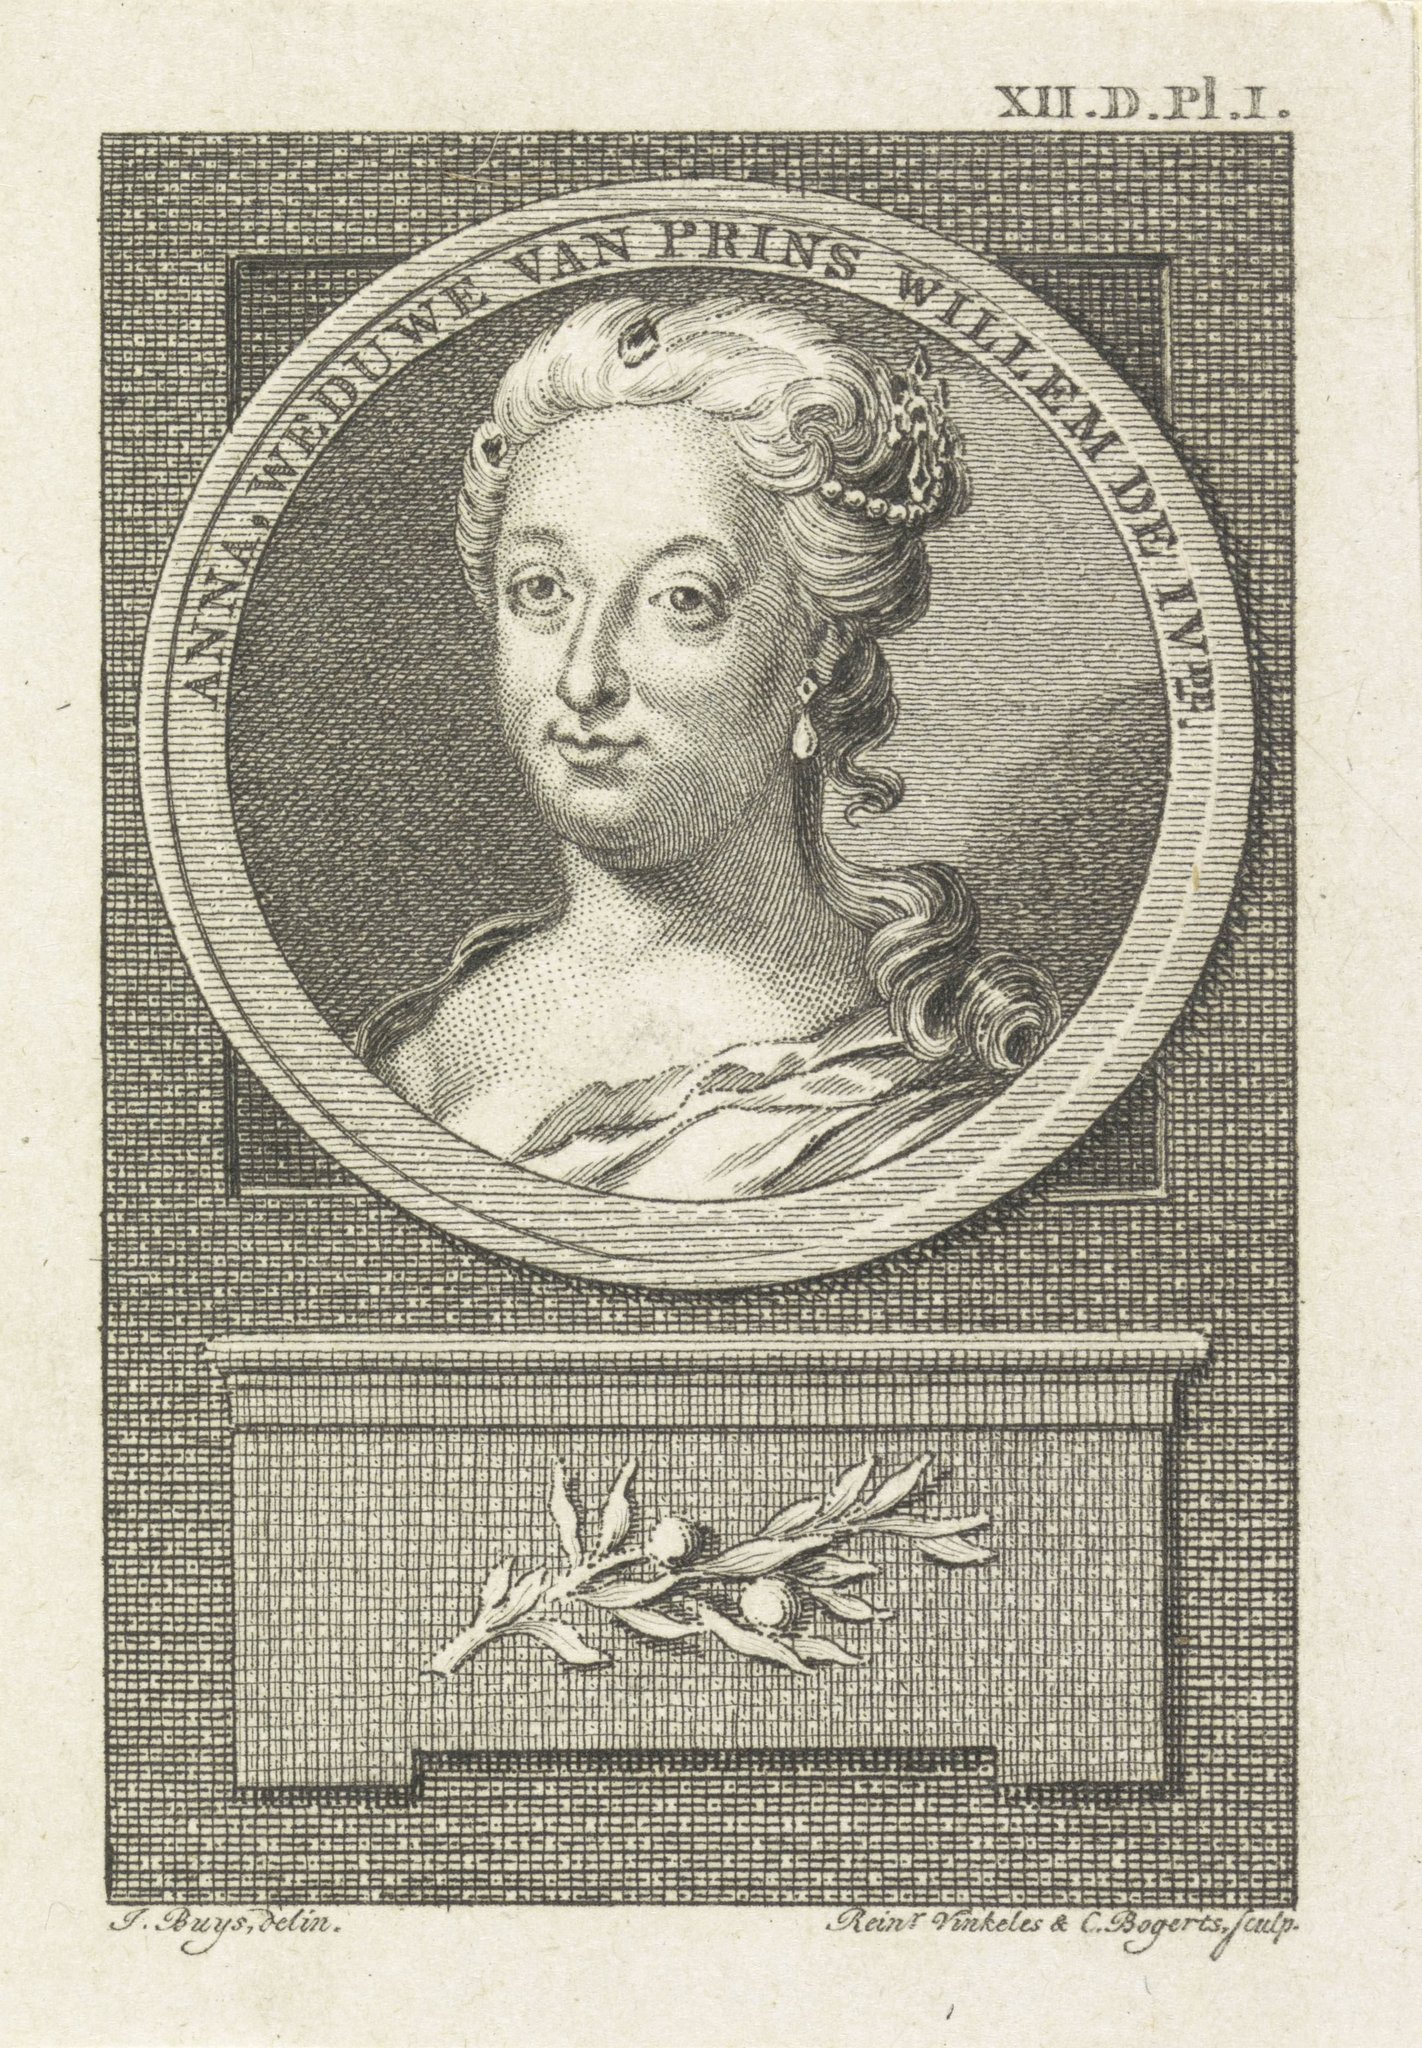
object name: print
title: Portret van Anna van Hannover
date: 1771-1816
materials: paper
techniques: engraving, etching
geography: amsterdam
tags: the hague, anna van hannover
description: Portret van Anna in een cirkel met randschrift. Op een voetstuk een oranjetak. Rechtsboven 'XXII .D .Pl .I .'.